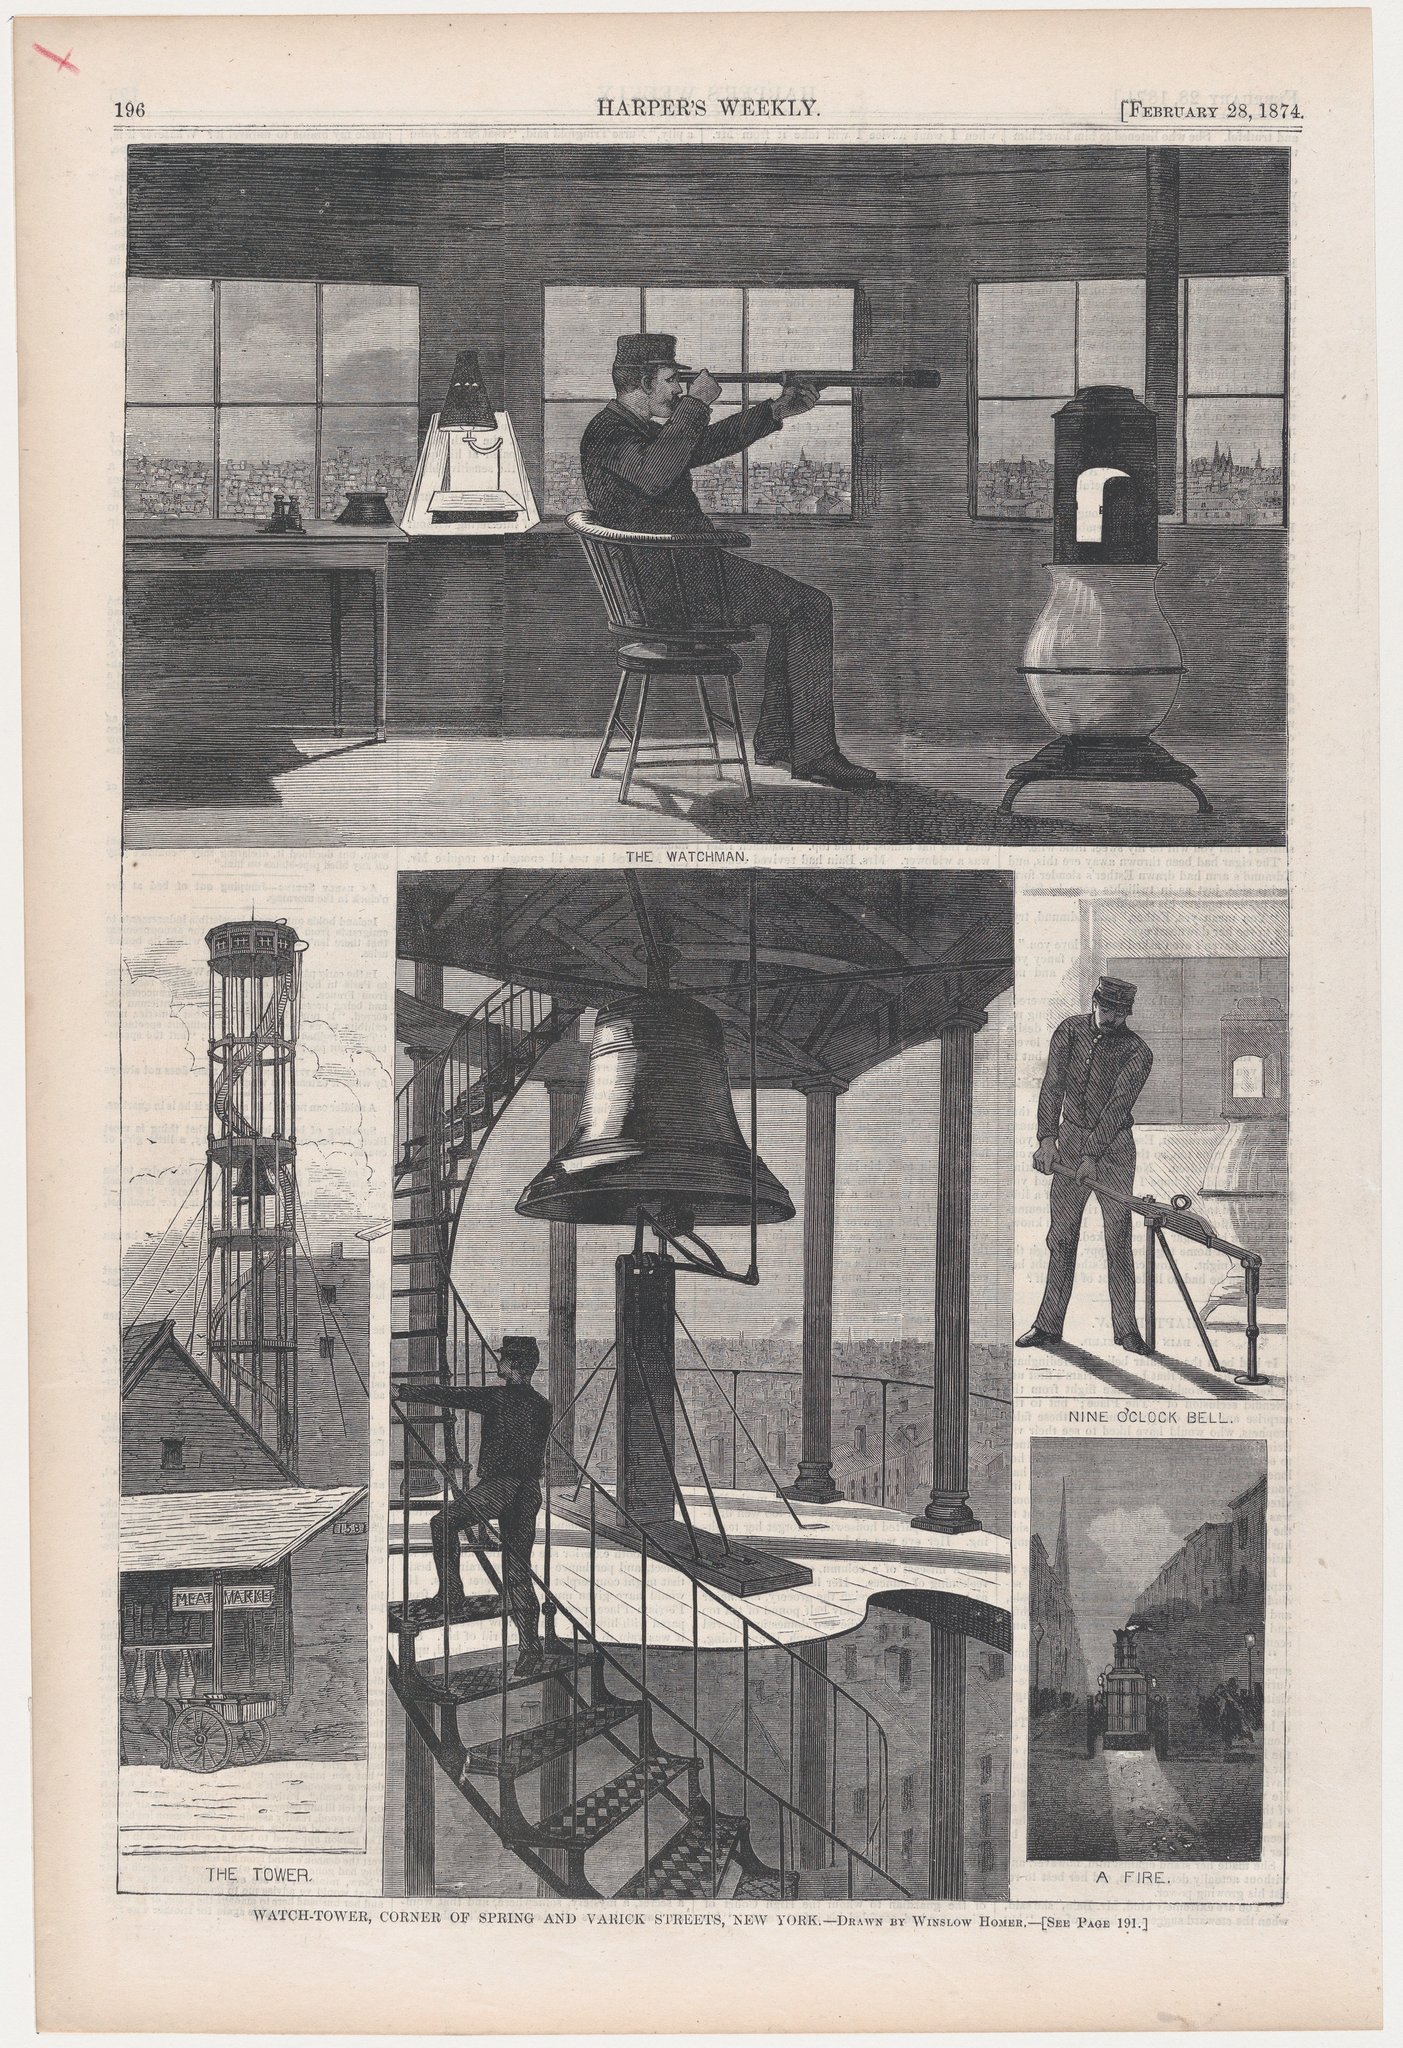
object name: print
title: Watch-Tower, Corner of Spring and Varick Streets (from "Harper's Weekly," Vol. XVIII)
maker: winslow homer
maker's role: artist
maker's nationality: american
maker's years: 1836-1910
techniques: engraving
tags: towers,men,telescopes